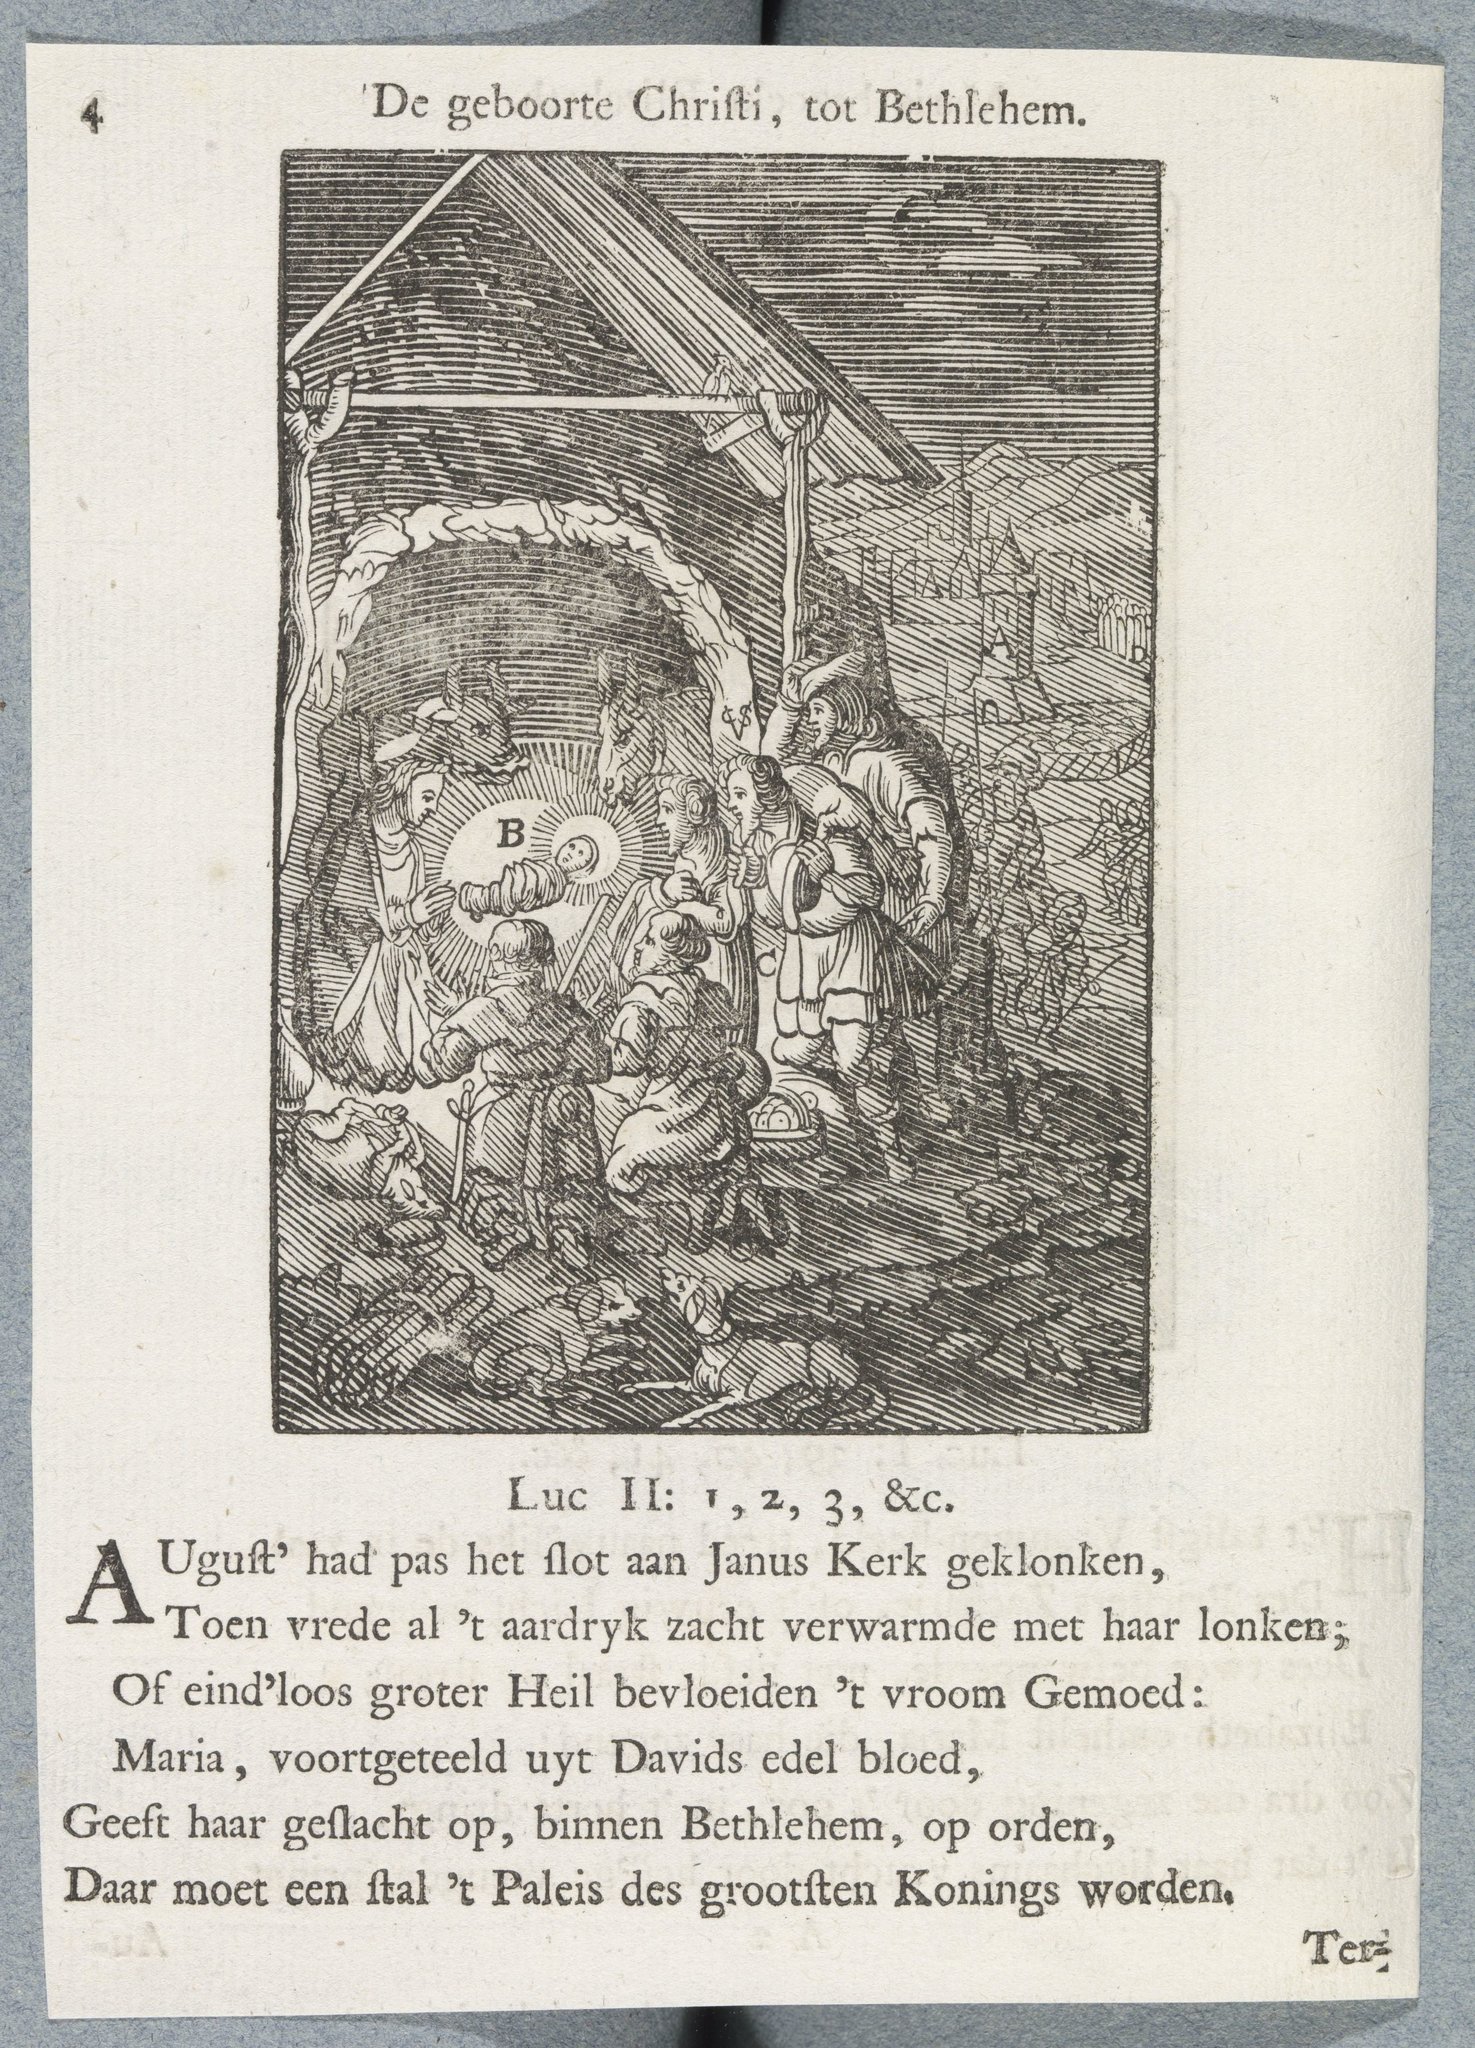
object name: album leaf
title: De geboorte Christi, tot Bethlehem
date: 1629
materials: paper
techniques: letterpress printing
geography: amsterdam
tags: adoration of the christ-child by the shepherds; mary and joseph present, dog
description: Maria, Jozef en de herders knielen in aanbidding voor het Christuskind dat in zijn kribbe in de stal ligt. Op de voorgrond twee honden. Bij verschillende elementen uit de voorstelling staan letters. Boven de voorstelling een titel. Eronder zes versregels en een verwijzing naar Lucas 2: 1-3. De prent maakt deel uit van een album.